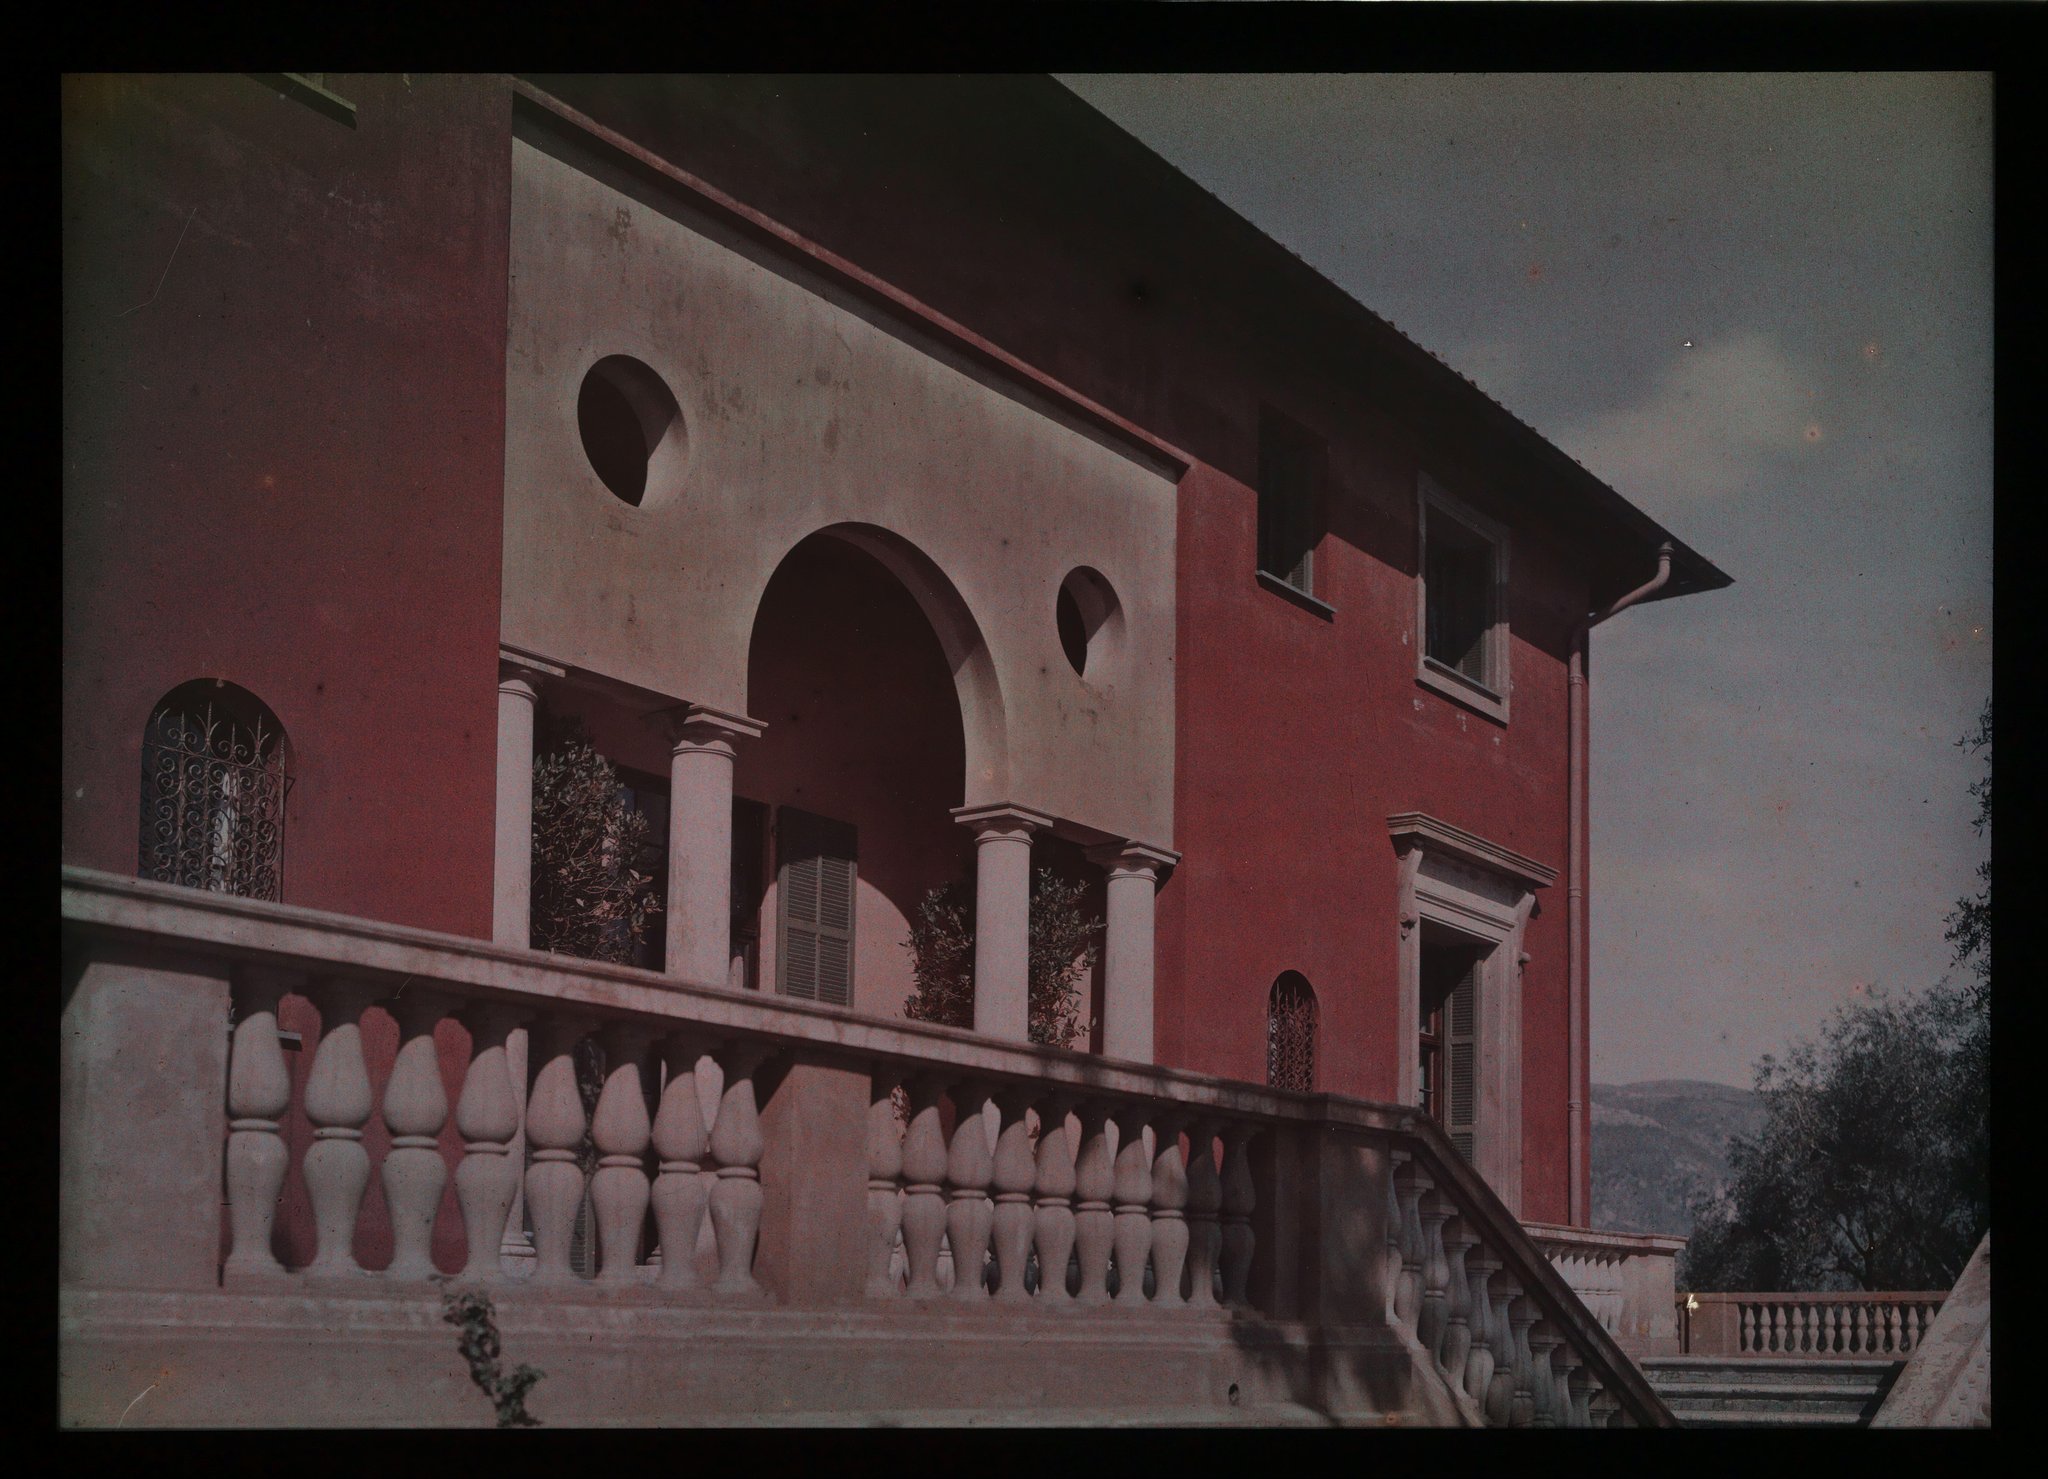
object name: photograph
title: Gedeelte van een roze gepleisterd huis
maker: Anonymous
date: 1910-1940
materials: glass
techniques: autochrome process